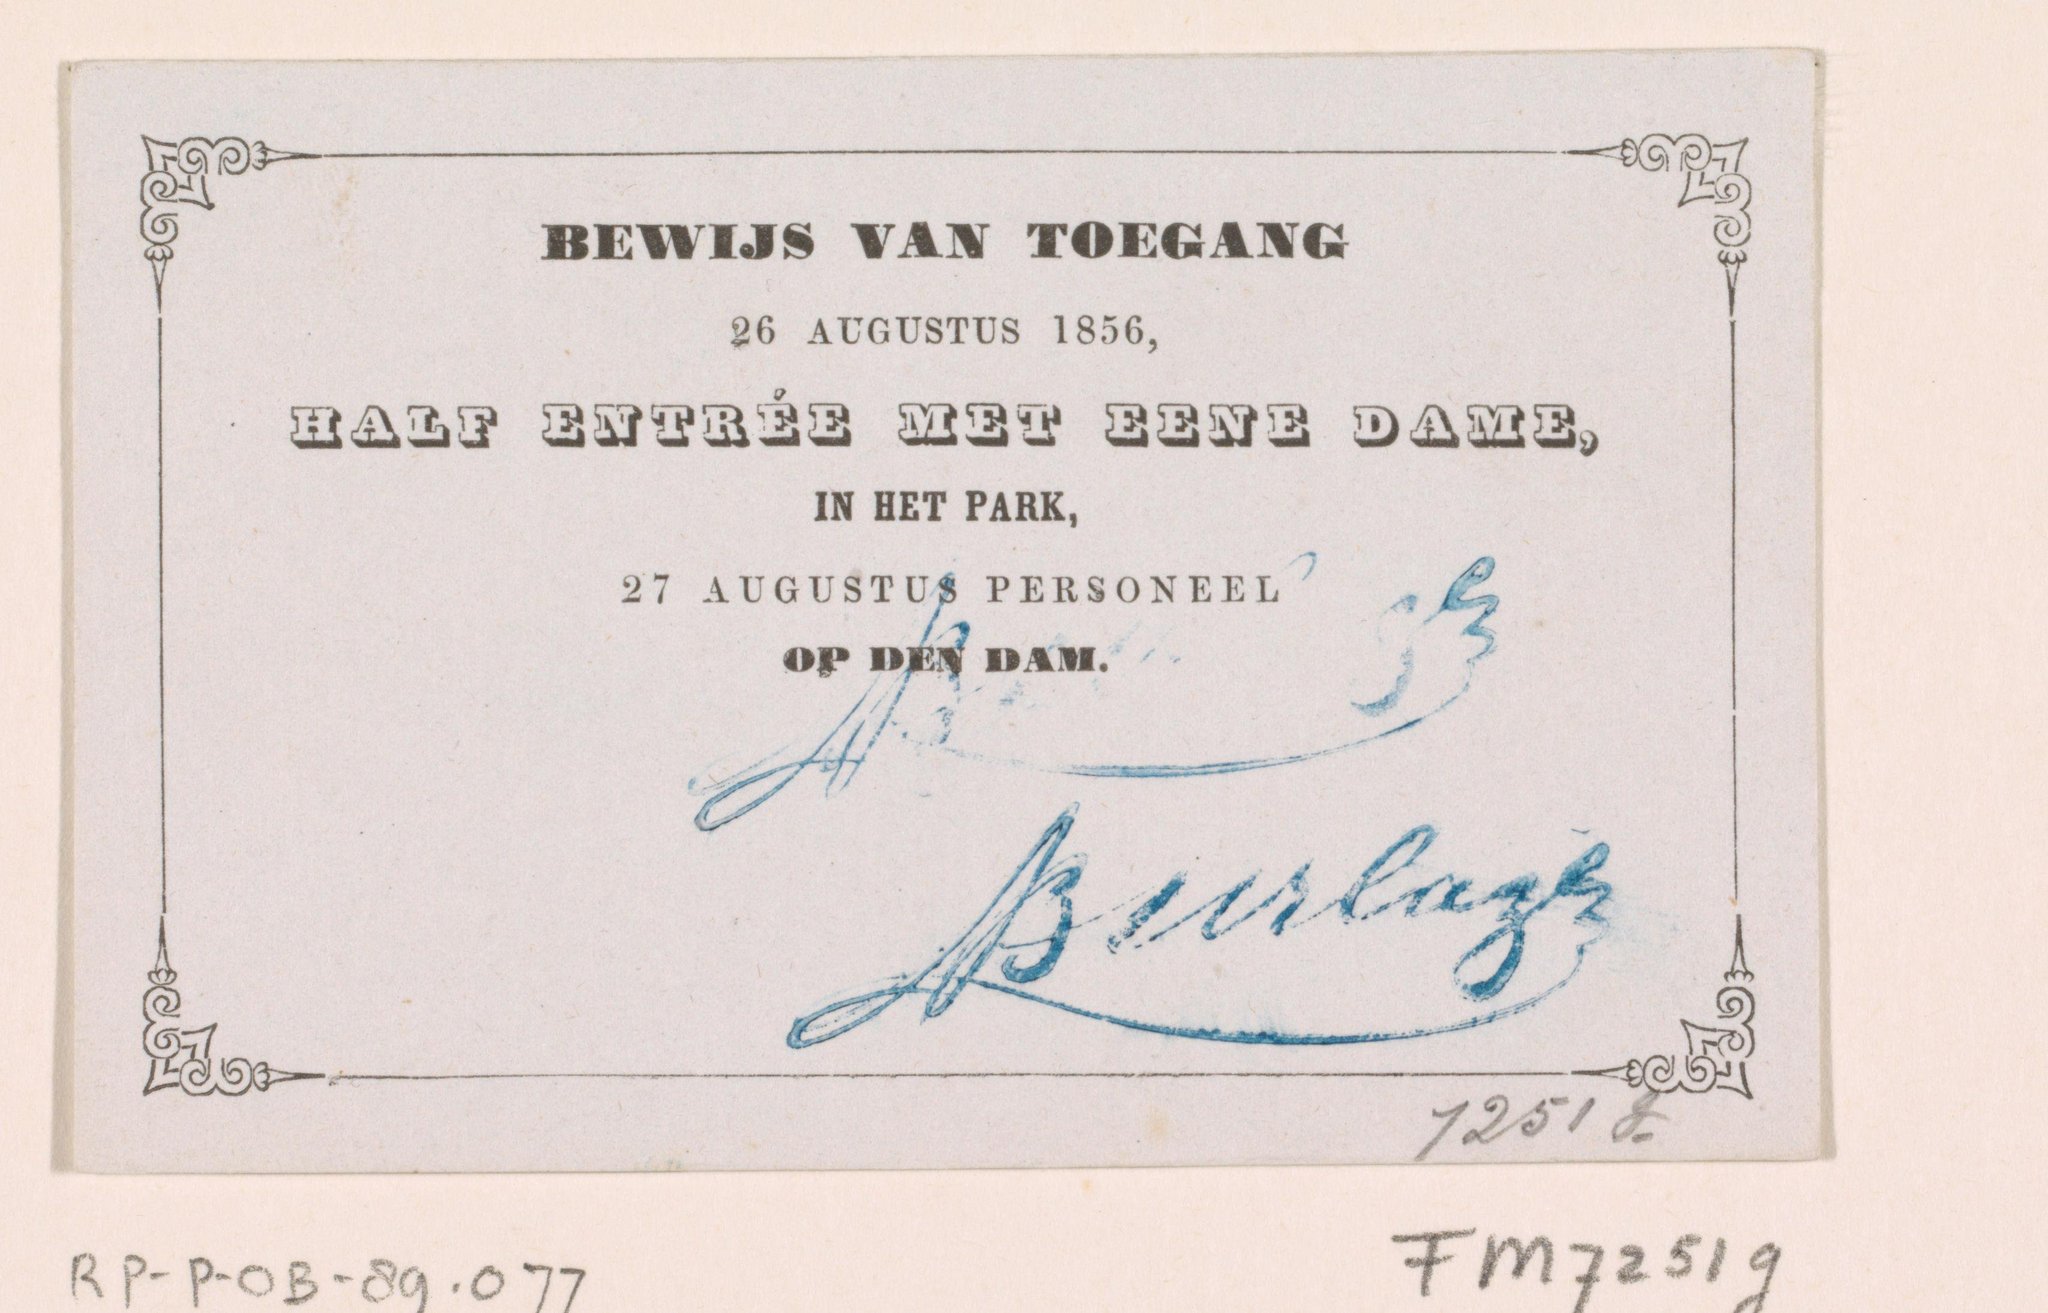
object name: admission ticket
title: Bewijs van Toegang 26 Augustus 1856, half entrée met eene dame, in het park, 27 Augustus personeel op den Dam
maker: Anonymous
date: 1856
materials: paper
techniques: letterpress printing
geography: amsterdam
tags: dam, naatje op de dam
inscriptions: collector's mark: Lugt 2228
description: Toegangsbewijs tot het park voor de feestelijkheden rond de onthulling van het monument Gedenkteken aan de Volksgeest van 1830 en 1831, bekend als Naatje op de Dam, te Amsterdam op 27 augustus 1856. Met een naam twee keer op de kaart gestempeld in blauw.